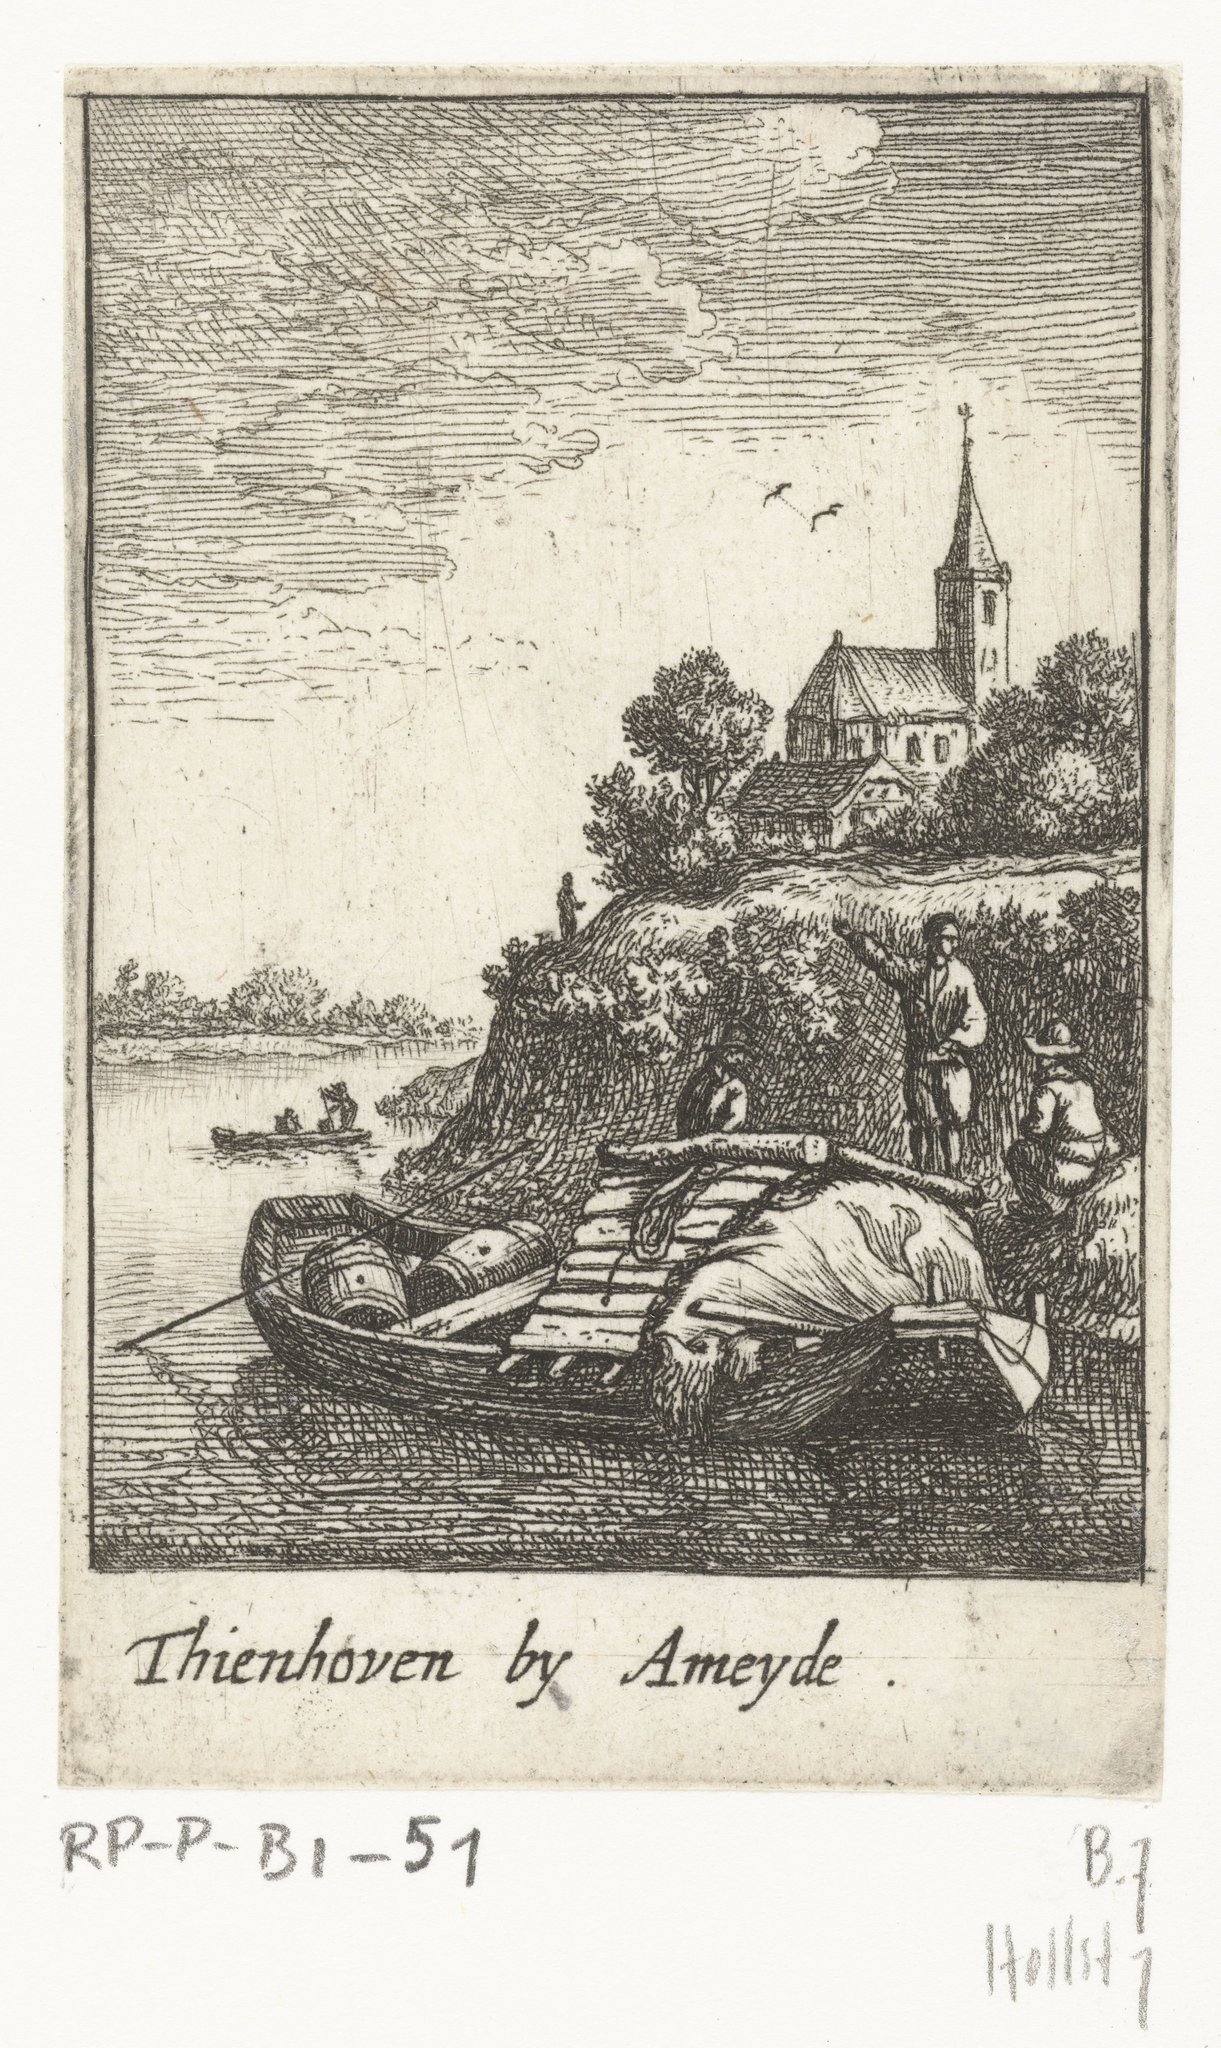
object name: print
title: Thienhoven by Ameyde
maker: jan van almeloveen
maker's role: draughtsman, print maker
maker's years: 1652-1683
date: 1662-1683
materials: paper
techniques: etching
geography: netherlands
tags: village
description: Gezicht op Tienhoven vanuit het water. Prent uit een serie van twaalf dorpsgezichten van Nederlandse plaatsen in de buurt van Utrecht met boten op de voorgrond.